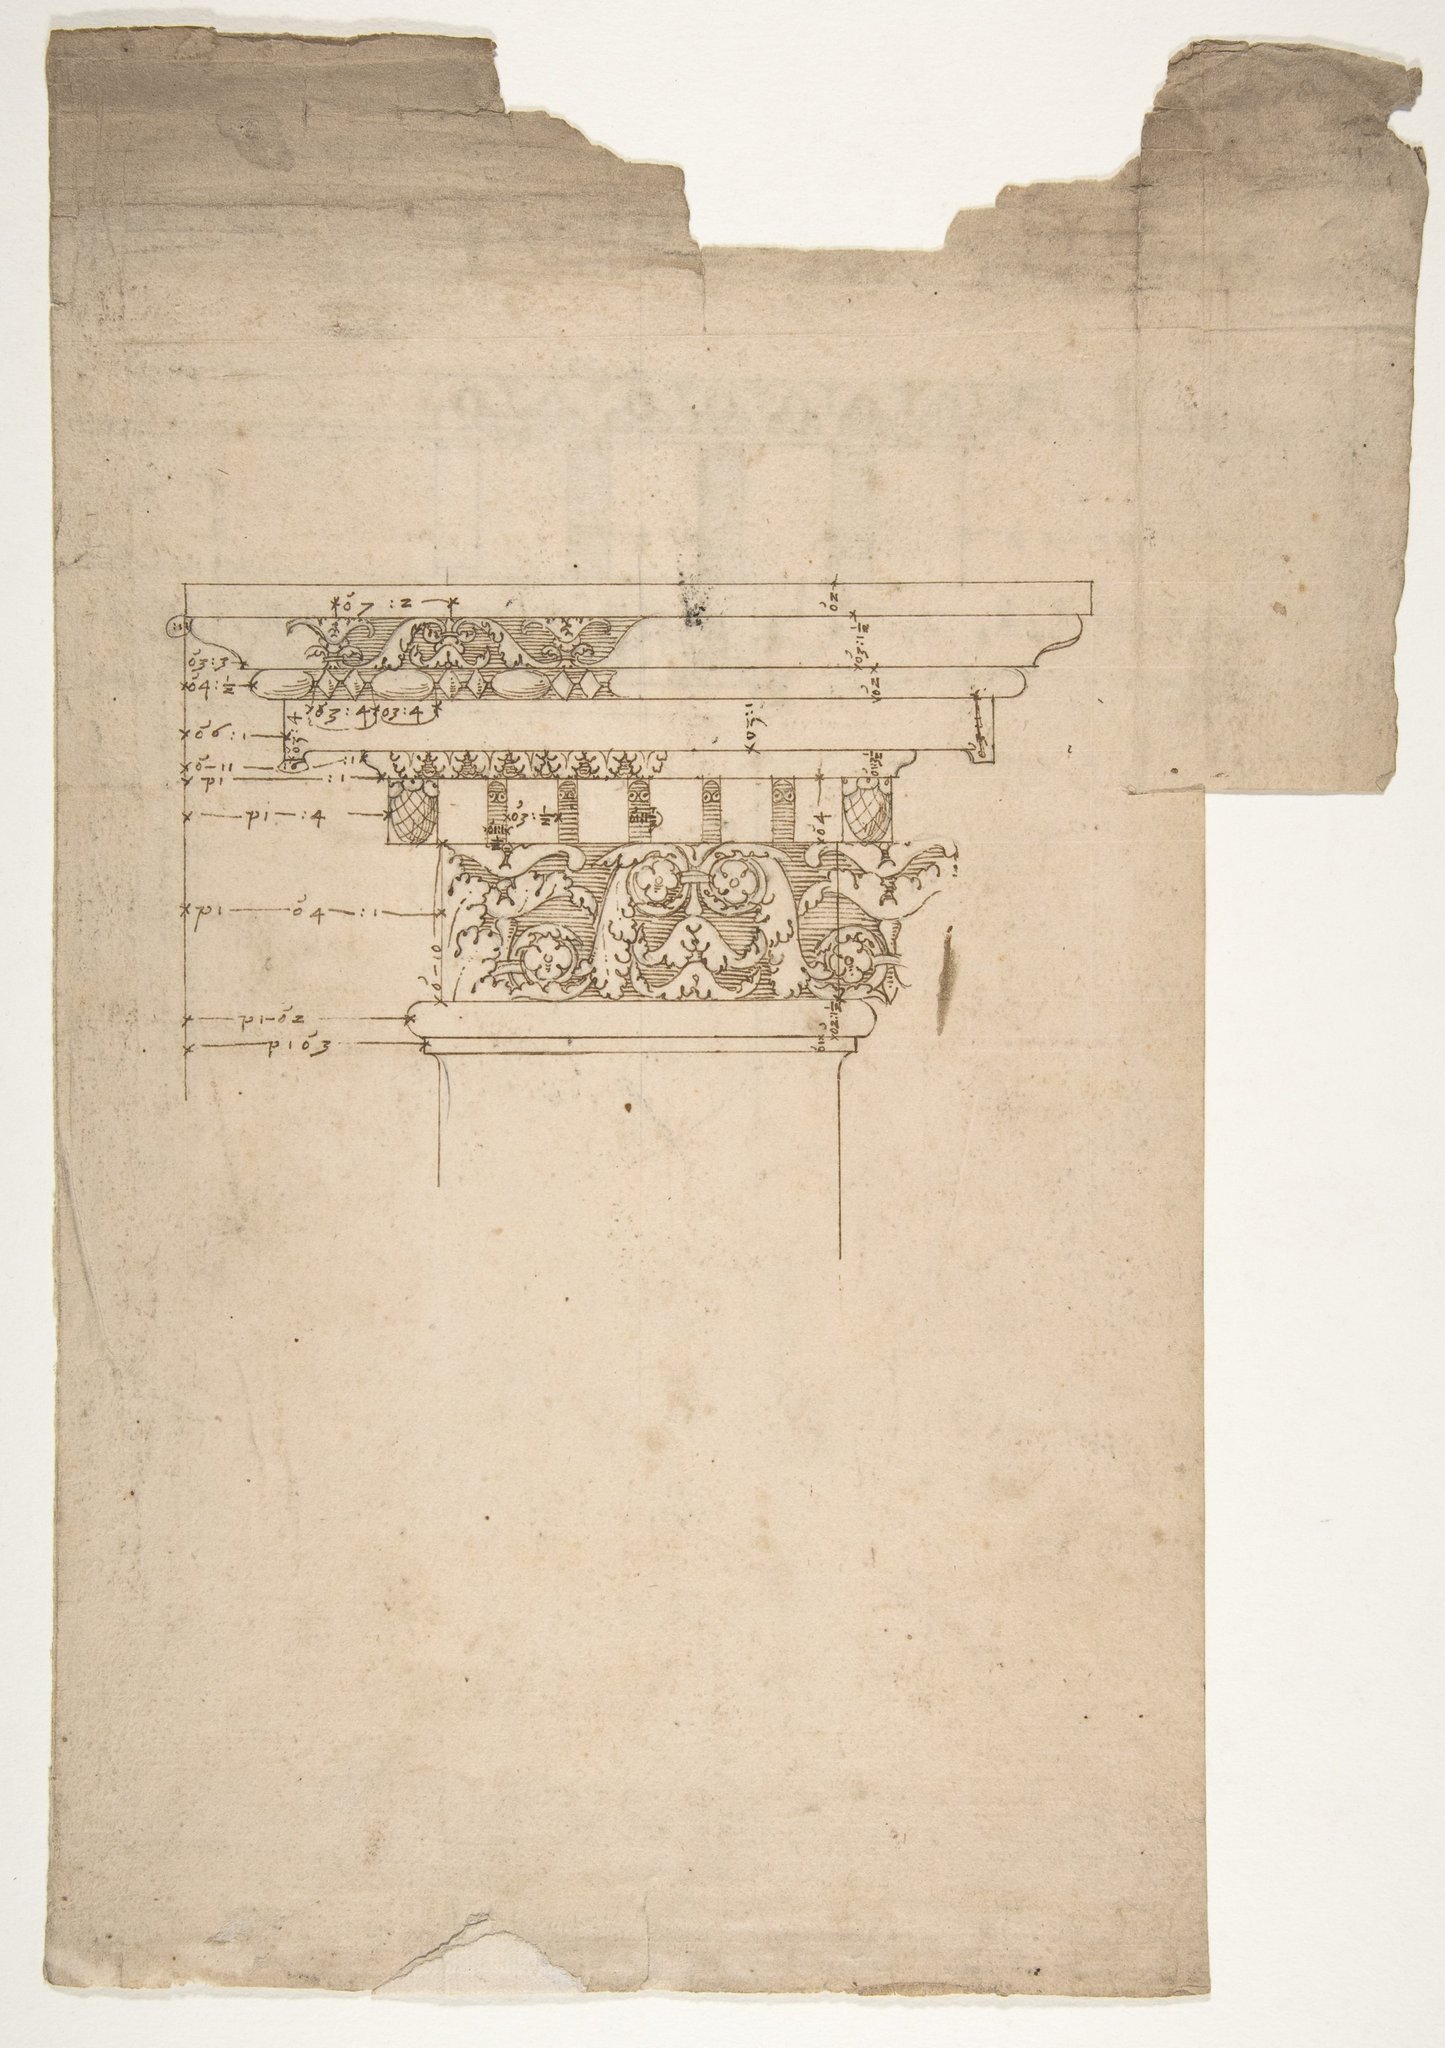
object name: collection ornament architecture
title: Arch of Septimius Severus, ornamental cornice and pilaster (recto) Arch of Septimius Severus, cornice with ornamental frame moulding (verso)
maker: anonymous, french, 16th century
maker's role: draftsman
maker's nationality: french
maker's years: 1500-1600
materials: chalk, ink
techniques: incising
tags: architecture